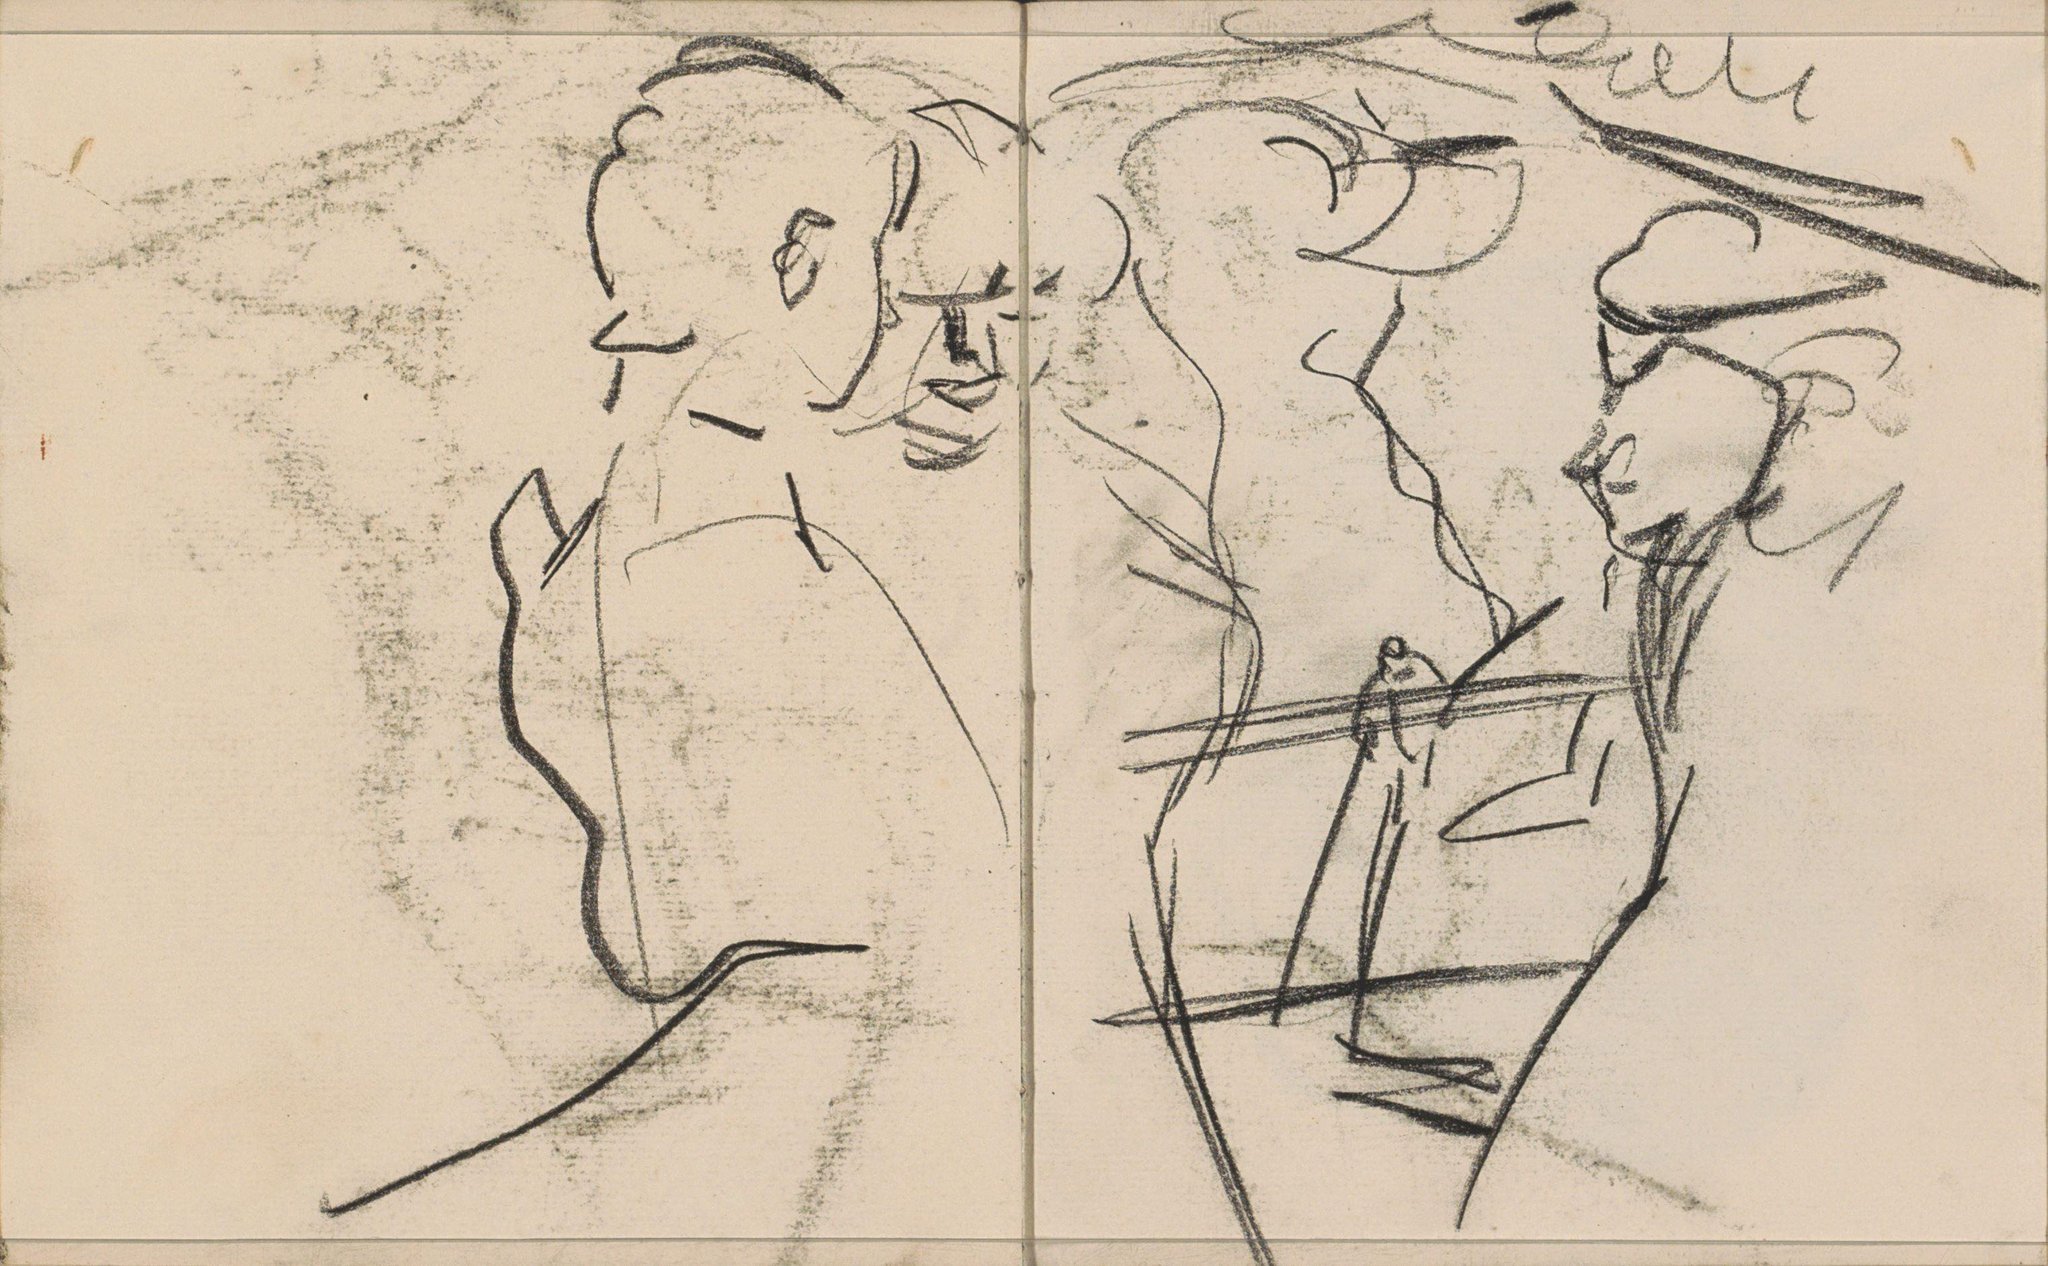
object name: sketchbook leaf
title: Groep vrouwen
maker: isaac israels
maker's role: draughtsman, painter, print maker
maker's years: 1865-1934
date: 1886-1903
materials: chalk, paper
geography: amsterdam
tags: adult woman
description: Pagina 30 en pagina 31 uit schetsboek XXXII met 92 pagina's.